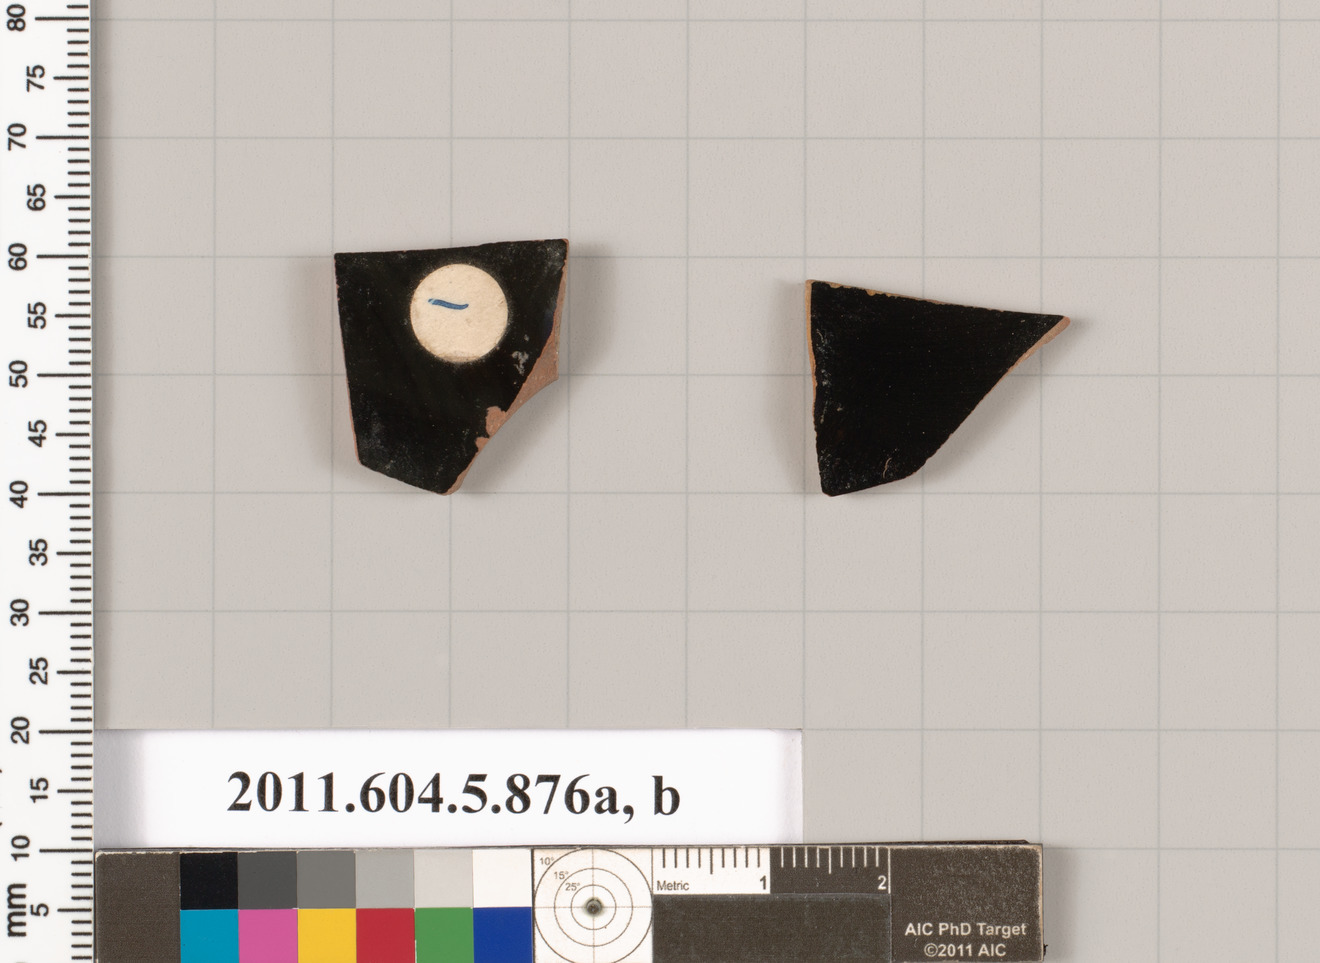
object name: kylix fragment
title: Terracotta fragments of kylikes (drinking cups)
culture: greek, attic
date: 600-401 BCE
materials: terracotta